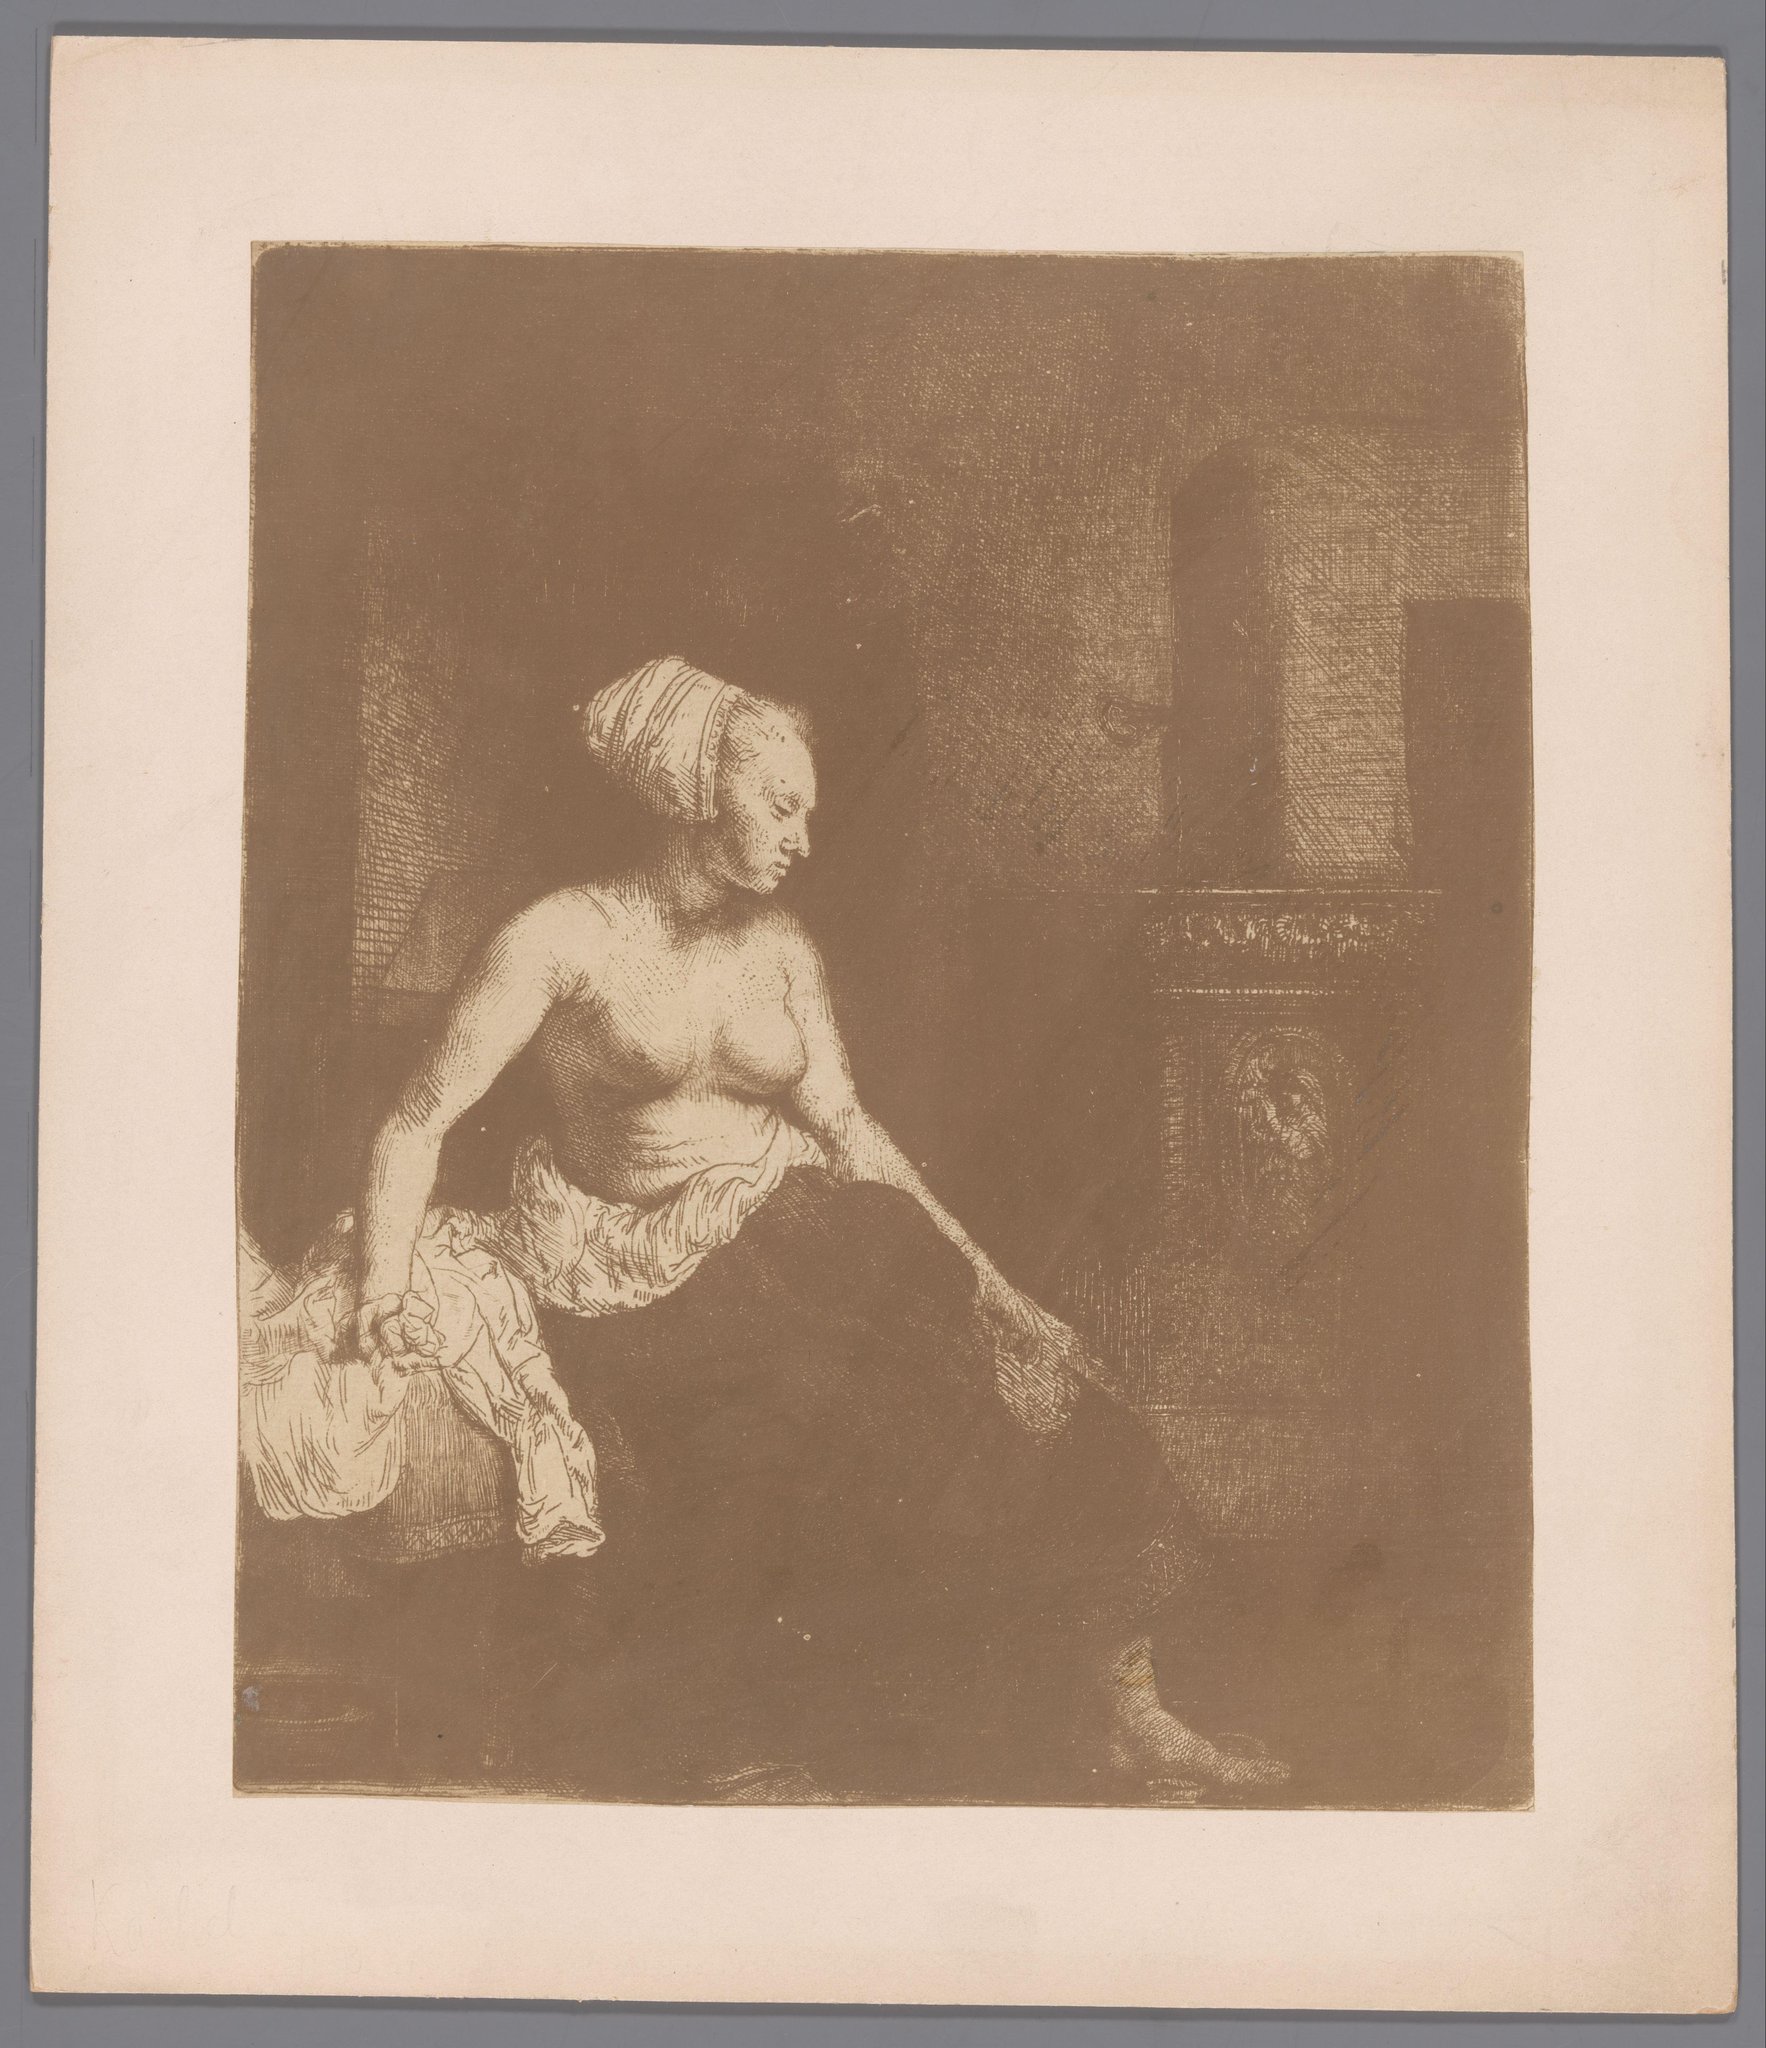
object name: reproduction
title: Fotoreproductie van een ets van een vrouw met naakt bovenlichaam bij een kachel door Rembrandt van Rijn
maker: Anonymous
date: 1900-1930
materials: cardboard, paper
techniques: gelatin silver print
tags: amsterdam, painter, print maker, draughtsman, rembrandt van rijn, print, e.g.: engraving, etching, lithograph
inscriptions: inscription: ‘41 B 21’, inscription: ‘Kachel’